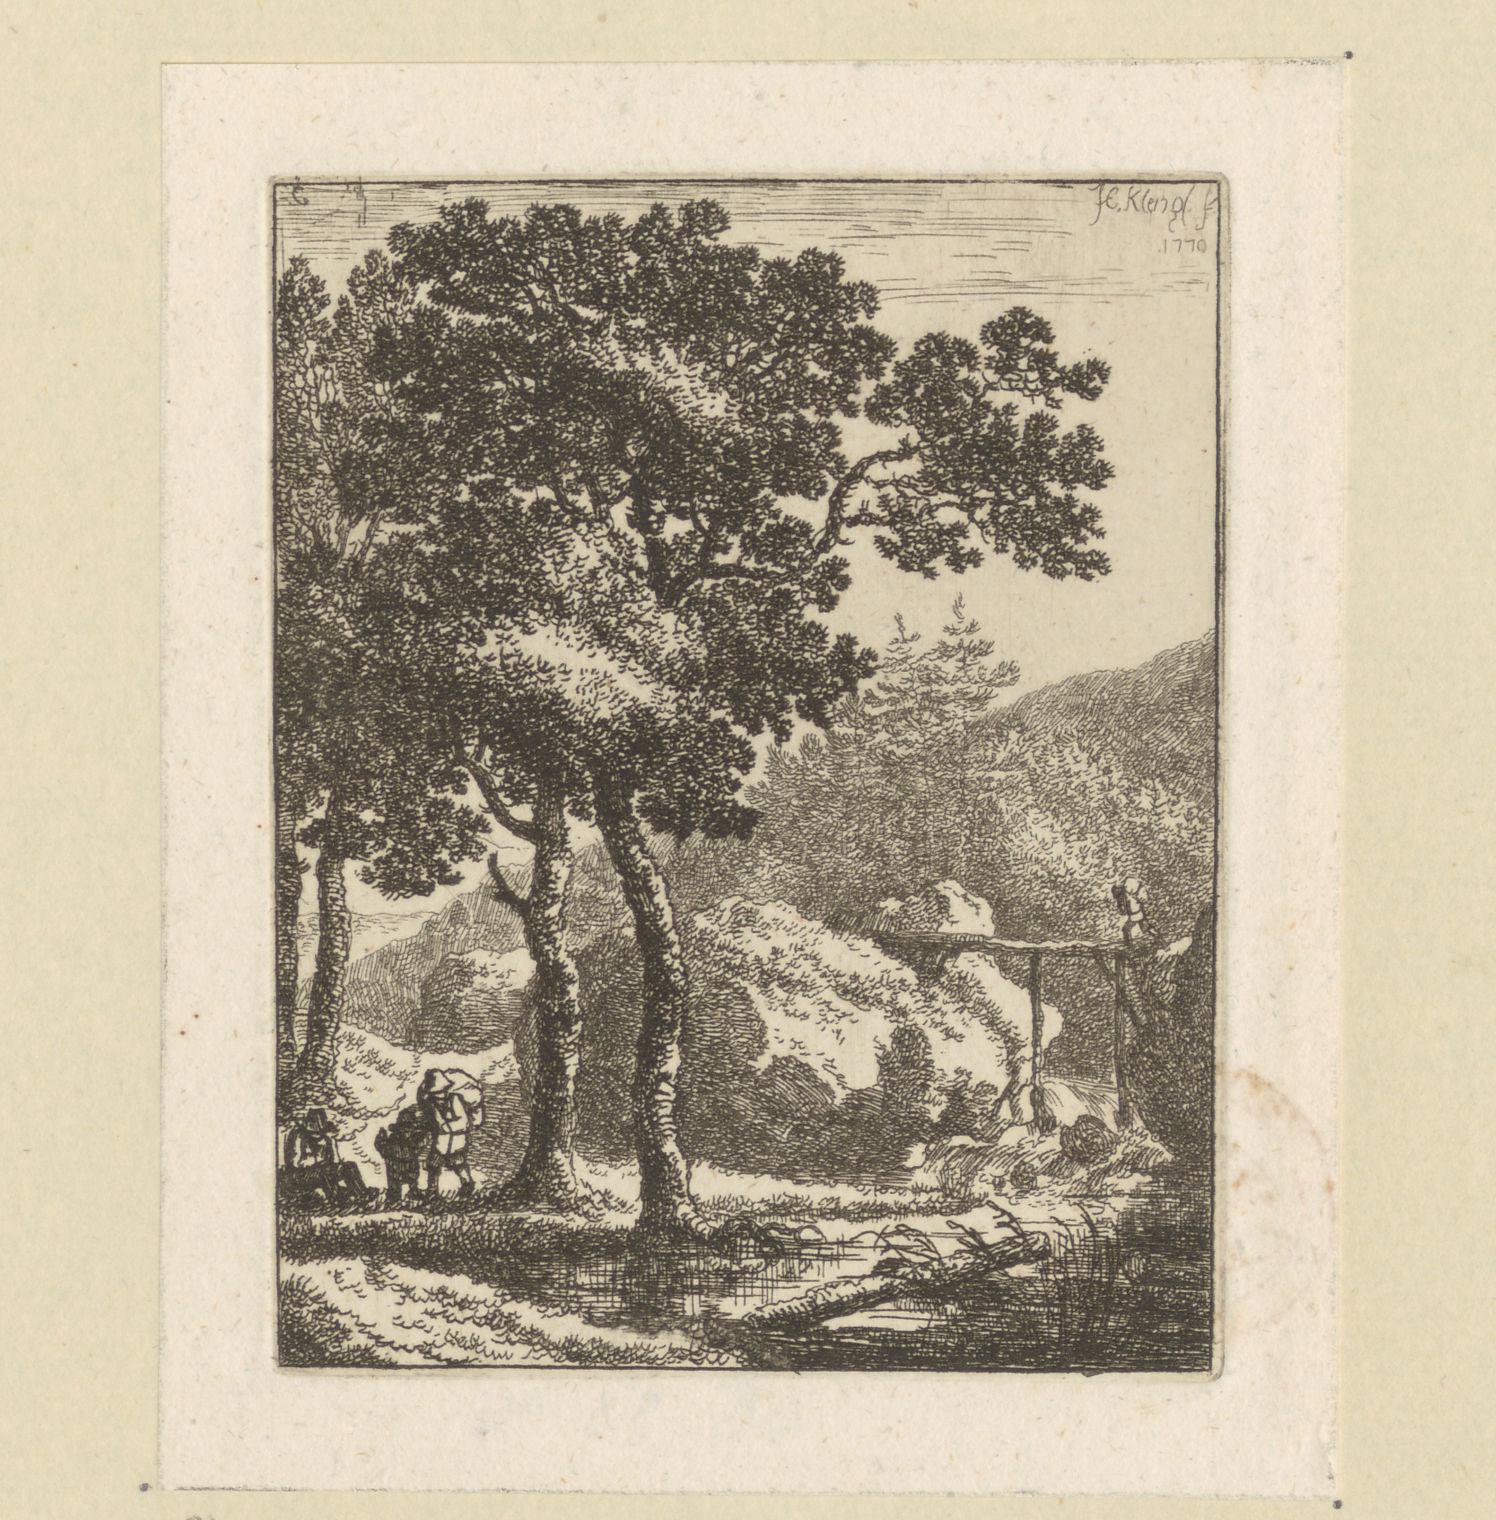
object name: print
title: Landschap met reizigers en een houten brug bij een waterval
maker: johann christian klengel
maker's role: print maker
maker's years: 1751-1824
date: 1770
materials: paper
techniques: etching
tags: waterfall, landscape with bridge, viaduct or aqueduct, 'en route', traveller under way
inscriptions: collector's mark: Lugt 240